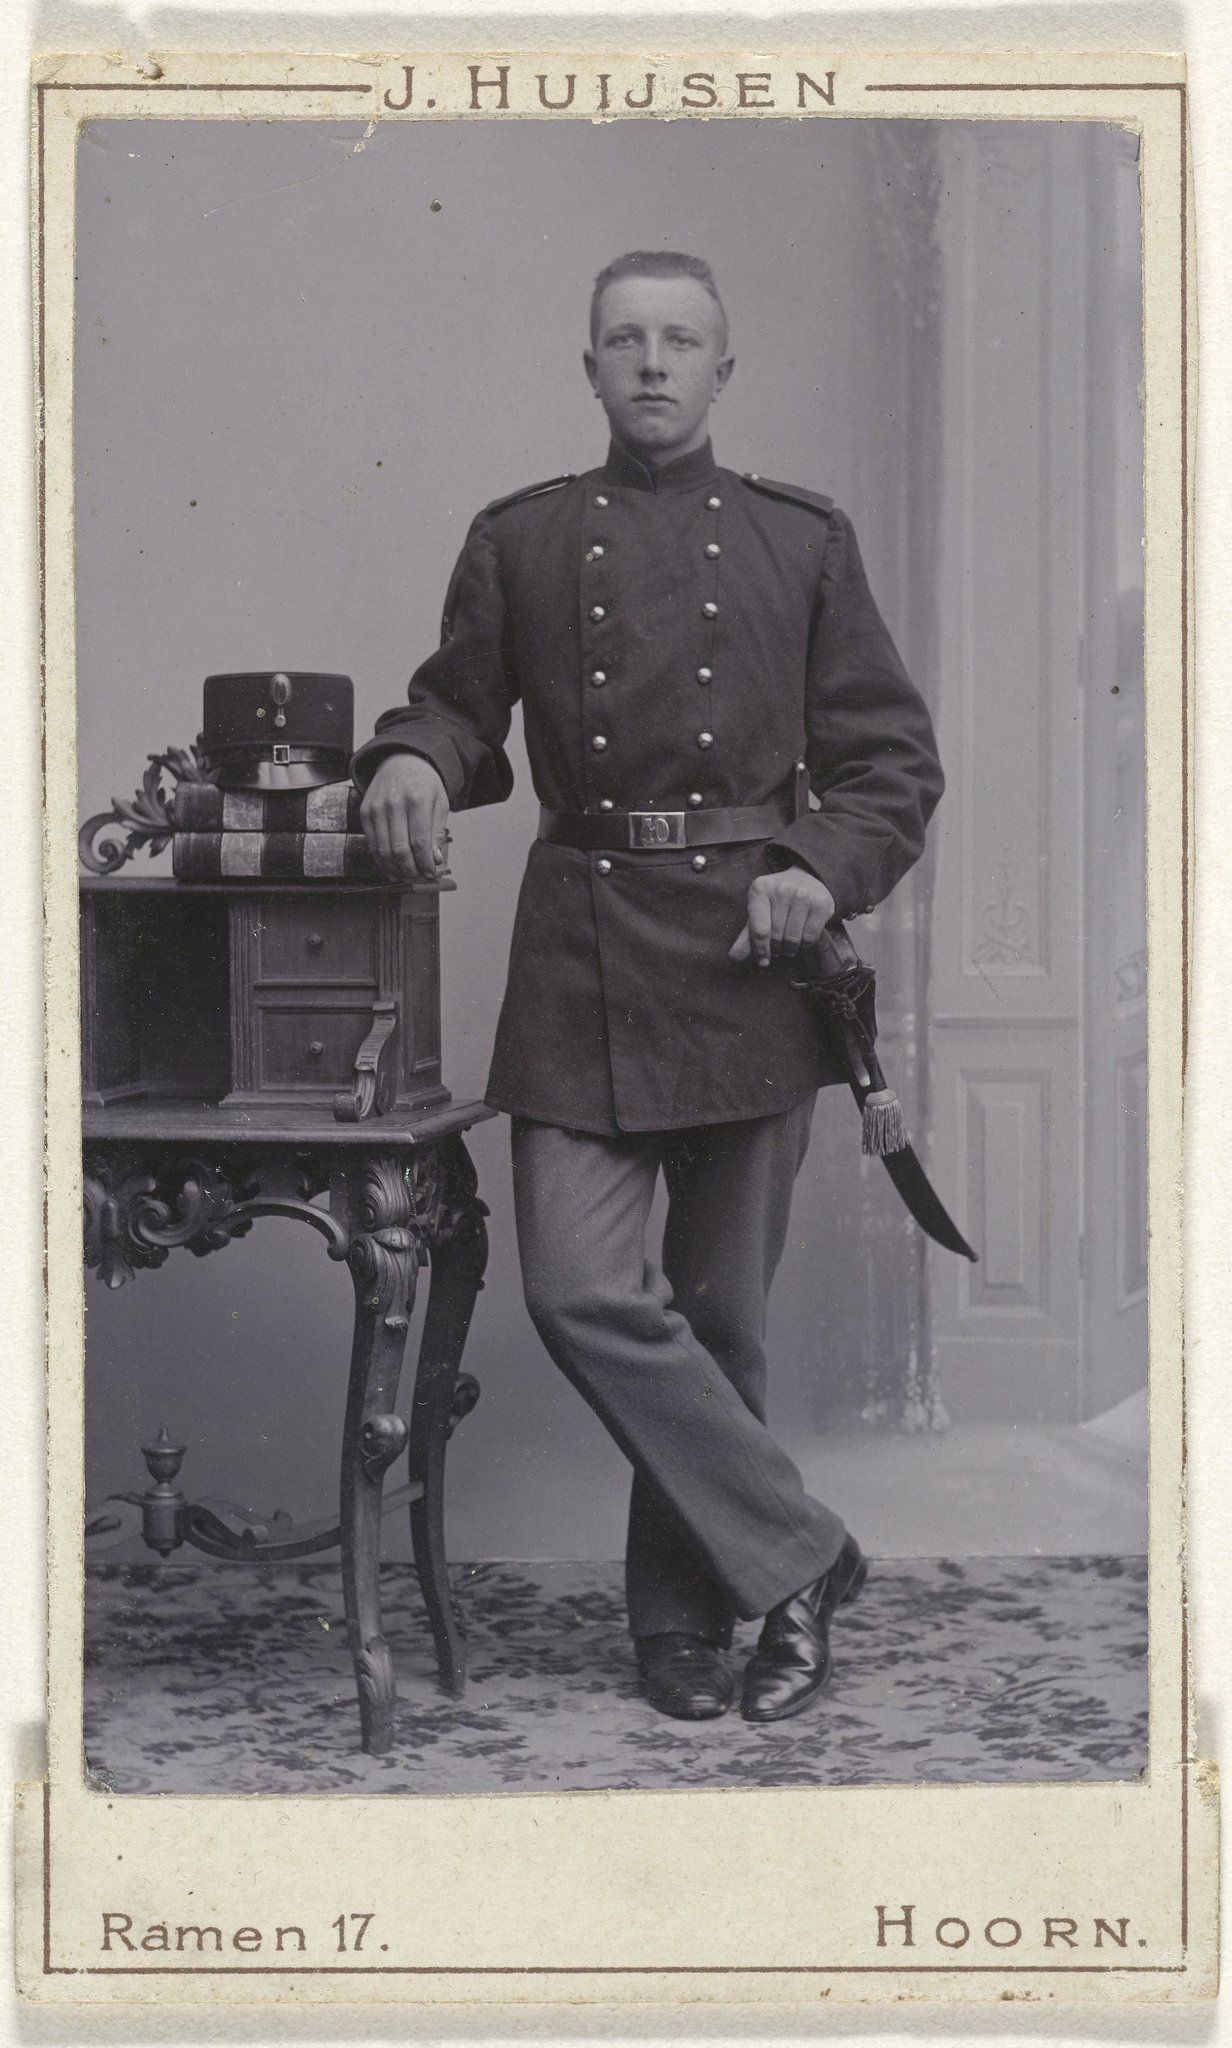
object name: carte de visite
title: Studioportret van man in uniform bij dressoir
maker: johannes laurens theodorus huijsen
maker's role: fotograaf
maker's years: 1852-1910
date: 1880-1920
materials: photographic support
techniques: albumen print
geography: hoorn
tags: hoorn (north holland)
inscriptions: name: ‘J.L.T. Huijsen photographe bekroond op vreschillende tentoonstellingen Hoorn, Ramen 17’